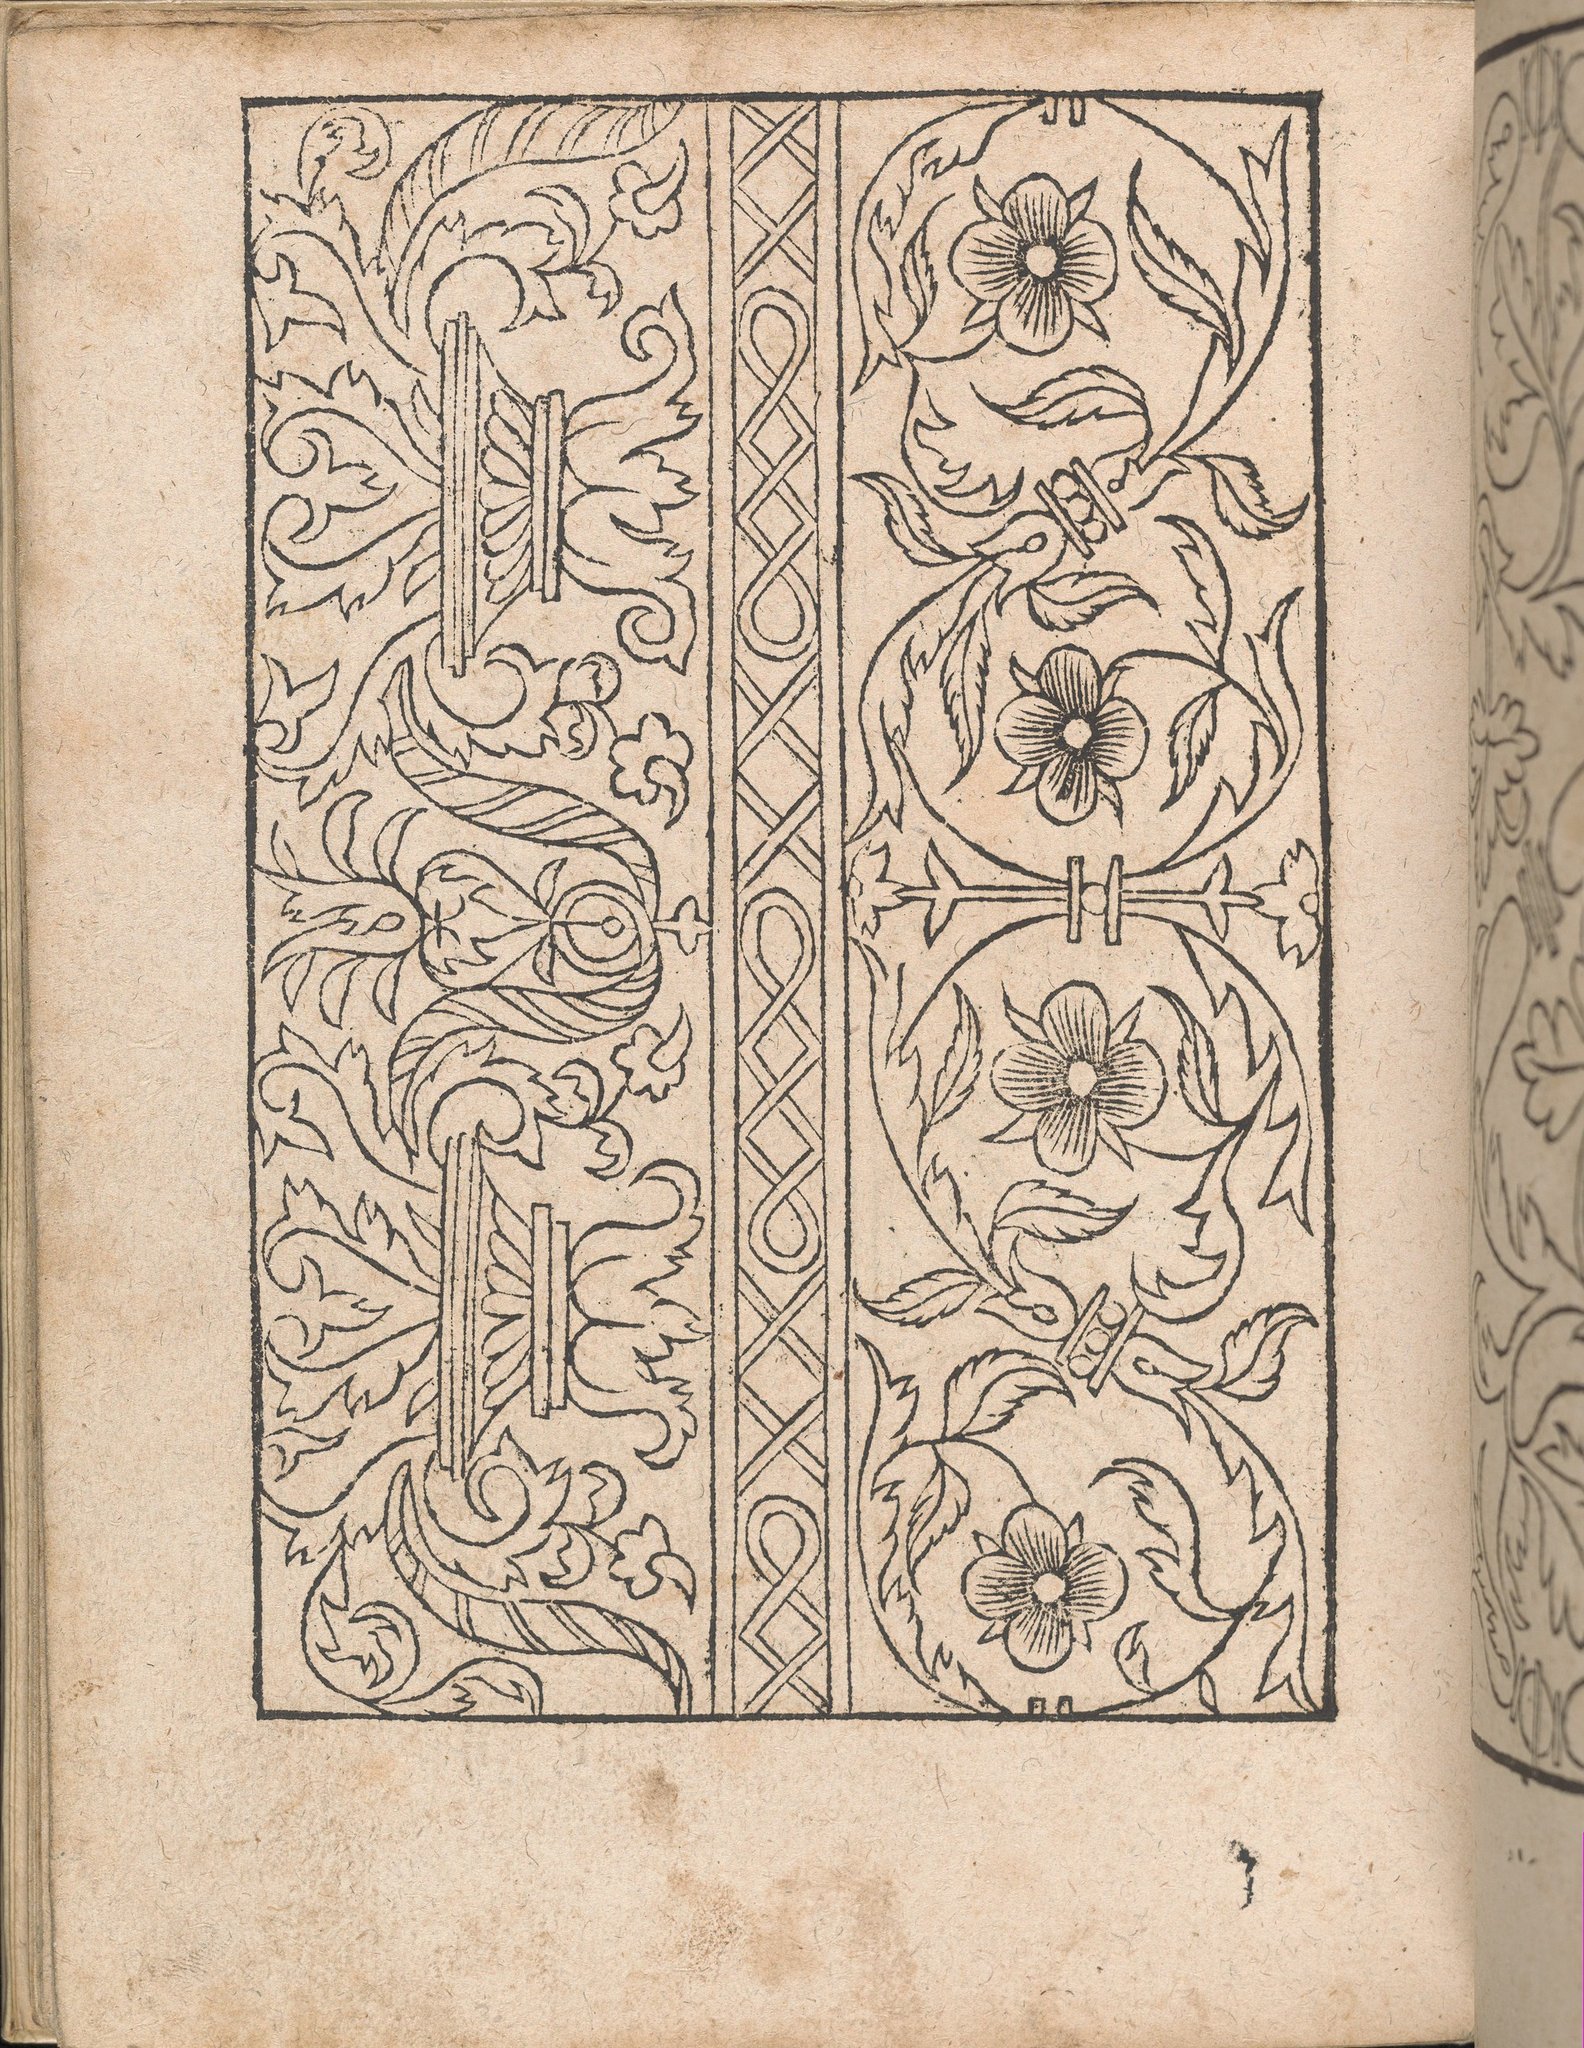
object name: book print ornament architecture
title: New Modelbüch allen Nägerin u. Sydenstickern (Page 23v)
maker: hans hoffman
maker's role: designer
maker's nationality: german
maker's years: 1556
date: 1556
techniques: woodcut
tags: flowers